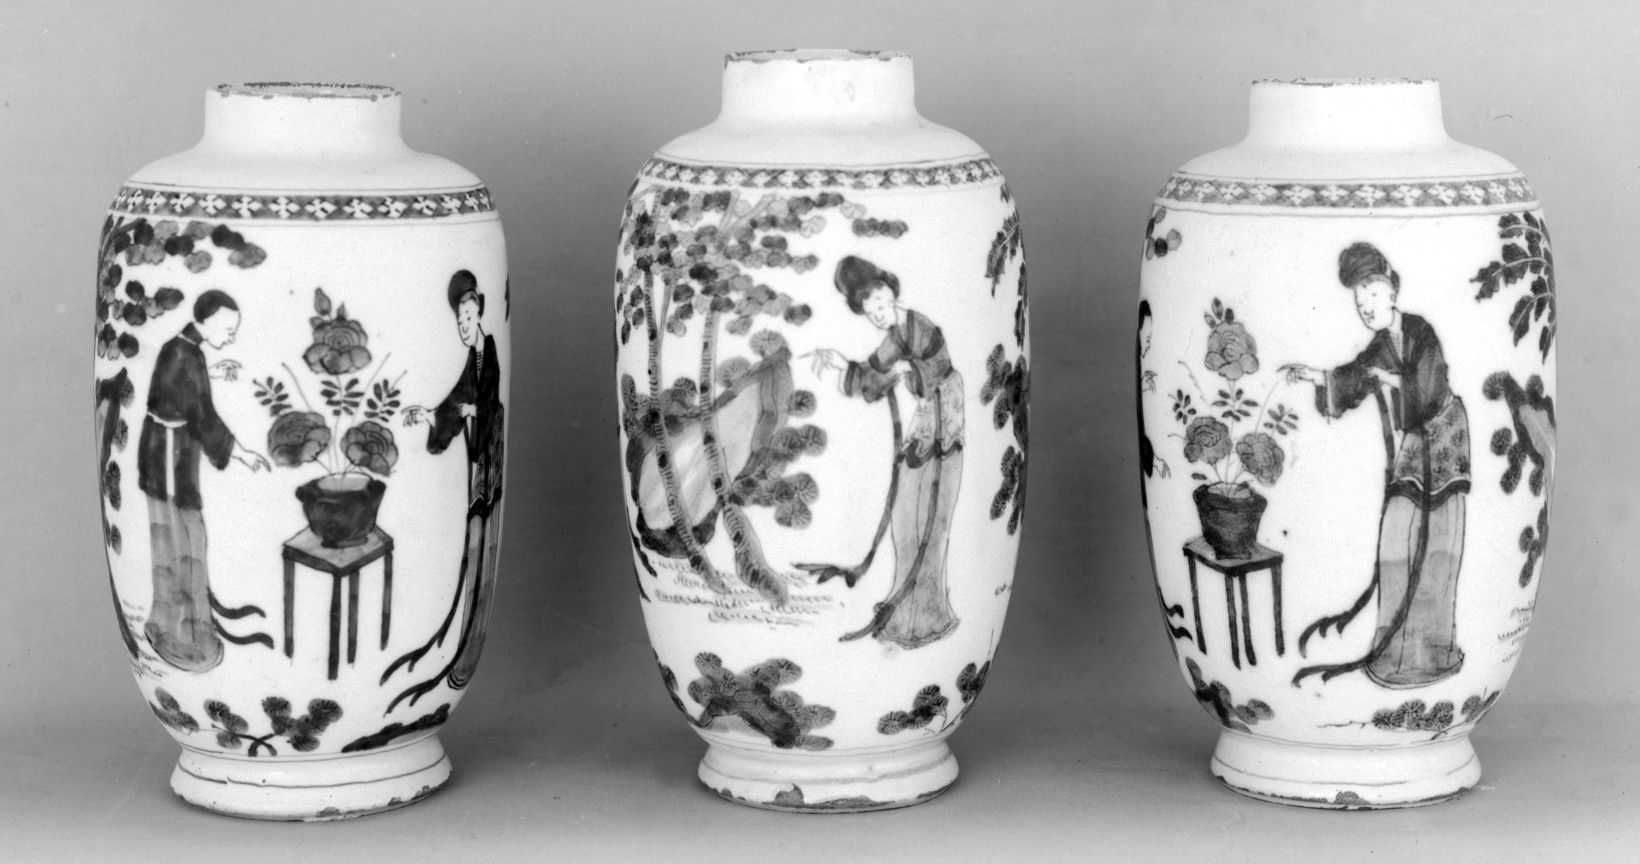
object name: vase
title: Vase (part of a garniture)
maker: de witte starre manufactory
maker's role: manufactory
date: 1723-1741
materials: earthenware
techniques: glazing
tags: women,flowers,trees